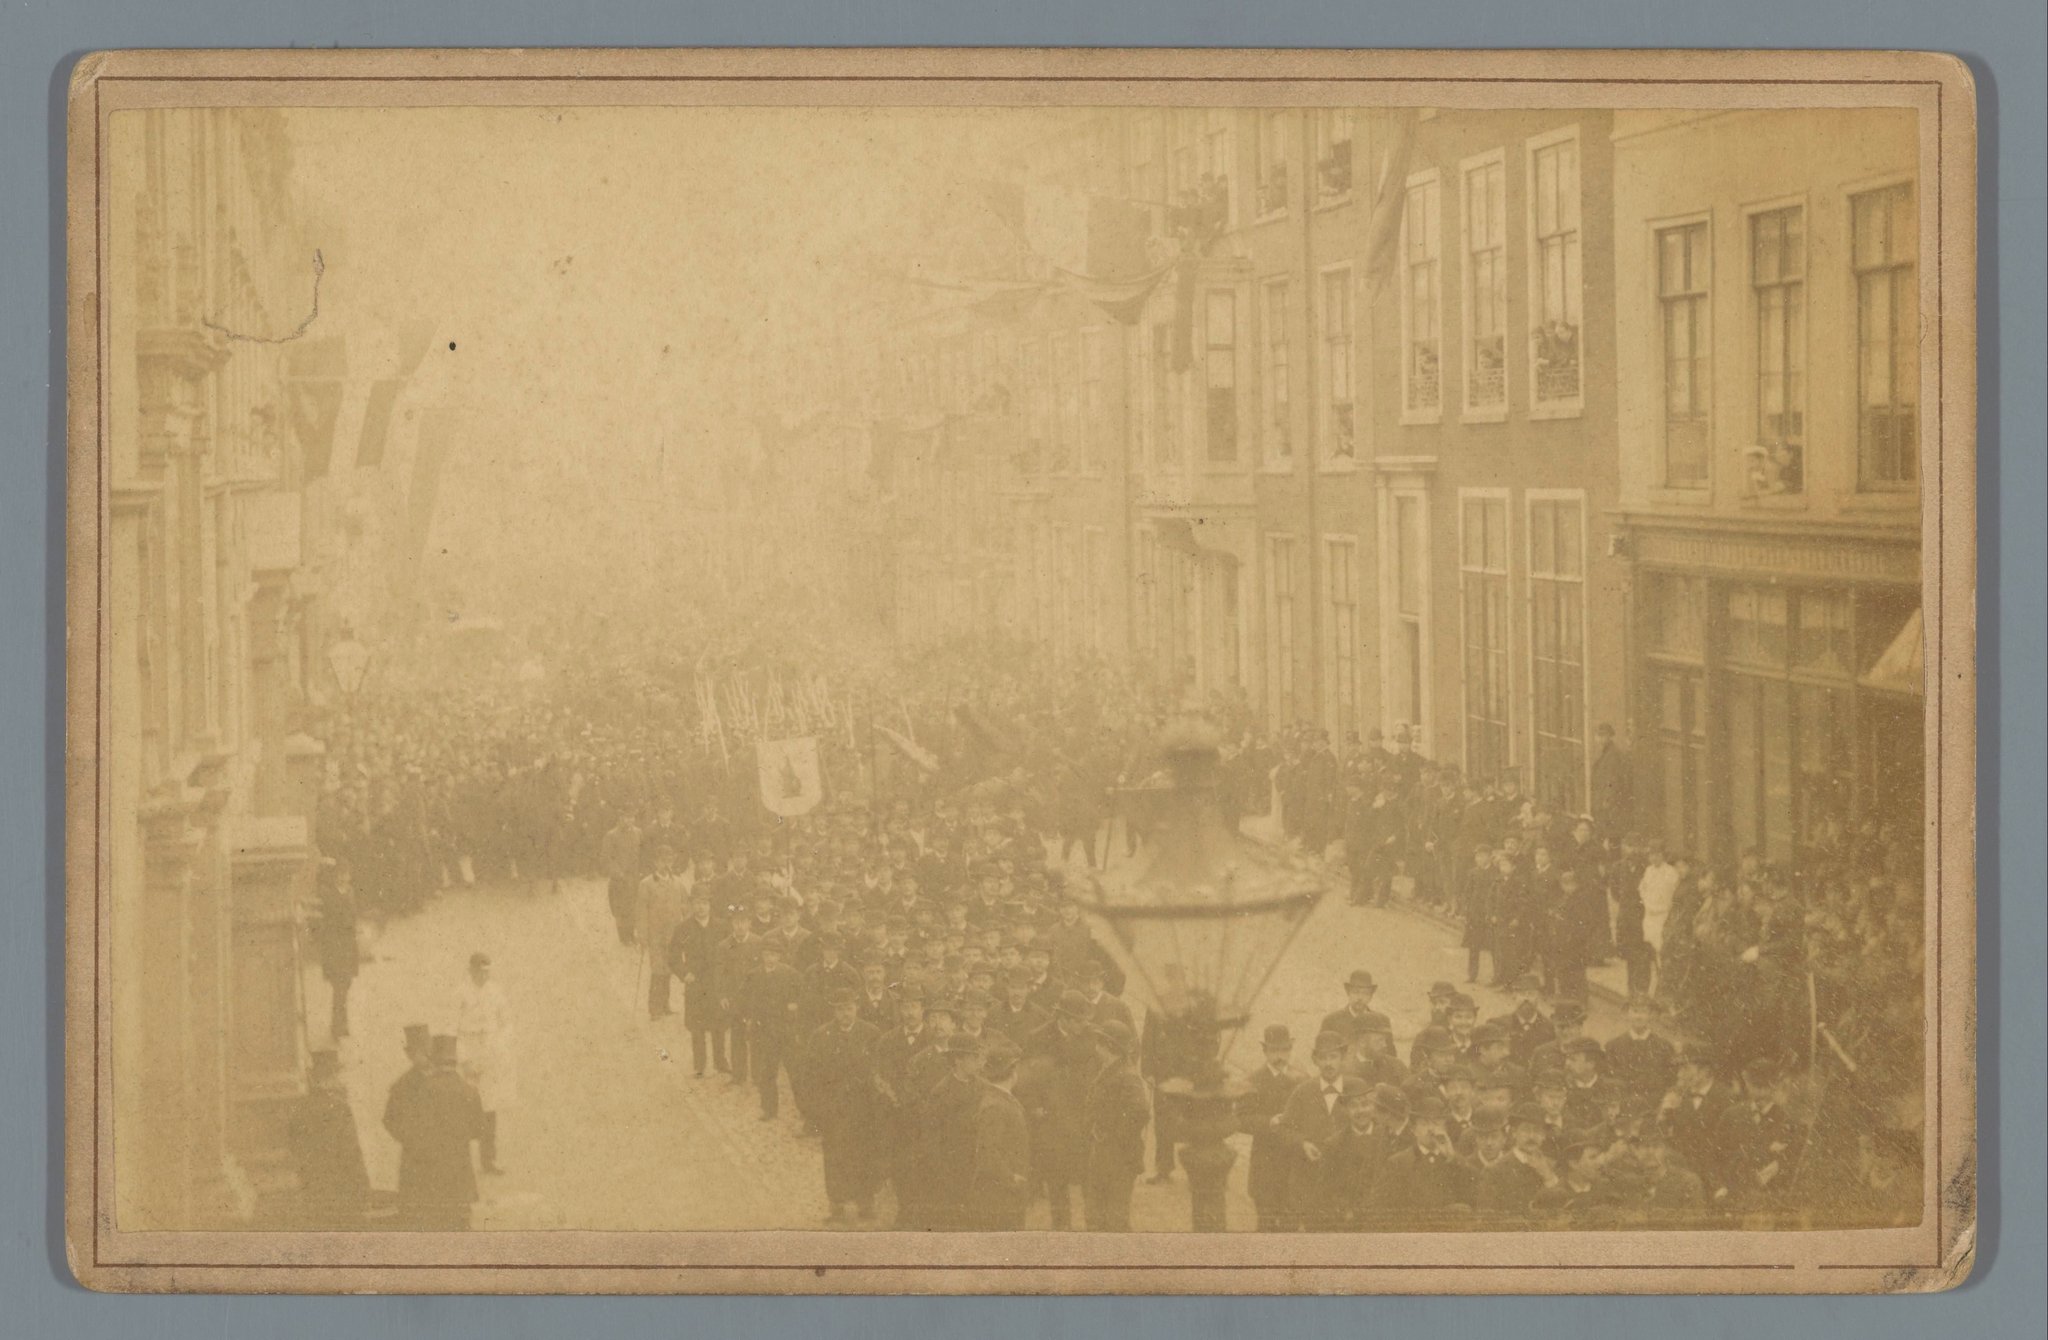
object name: photograph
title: Optocht door de Breestraat te Leiden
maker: Anonymous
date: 1850-1900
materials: cardboard, photographic support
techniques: albumen print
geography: leiden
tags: activities in the air ~ public festivities, e.g. fly-past (+ parade, pageant, cavalcade ~ festive activities)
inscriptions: retailer's mark: ‘J. van der Schouw/ Binnen- & Buitenlandsche/ Boek-& Kunsthandel/ Breestraat 110,/ Leiden.’